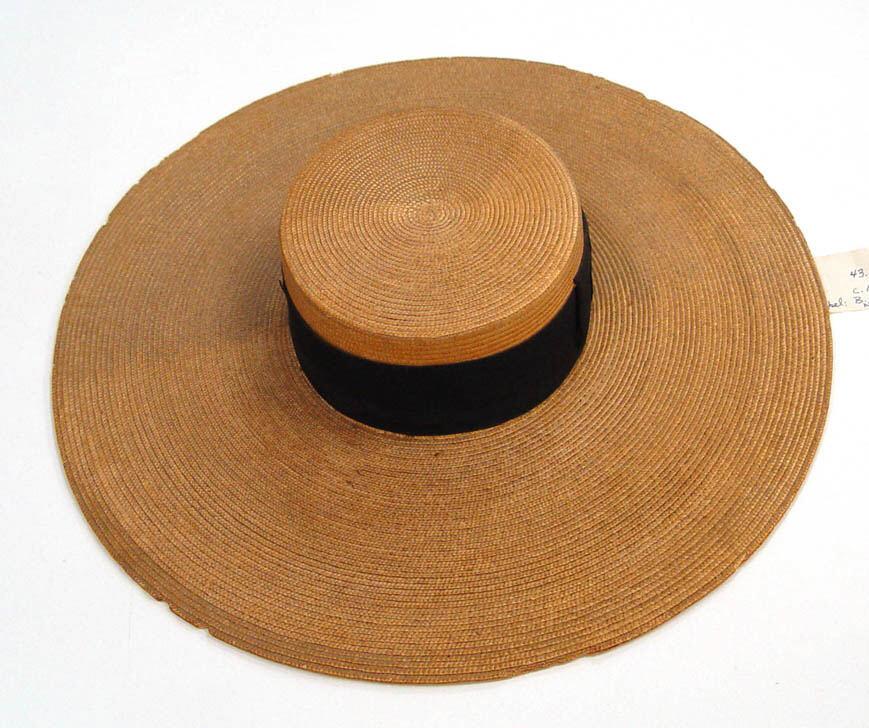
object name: hat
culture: american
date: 1900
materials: fiber